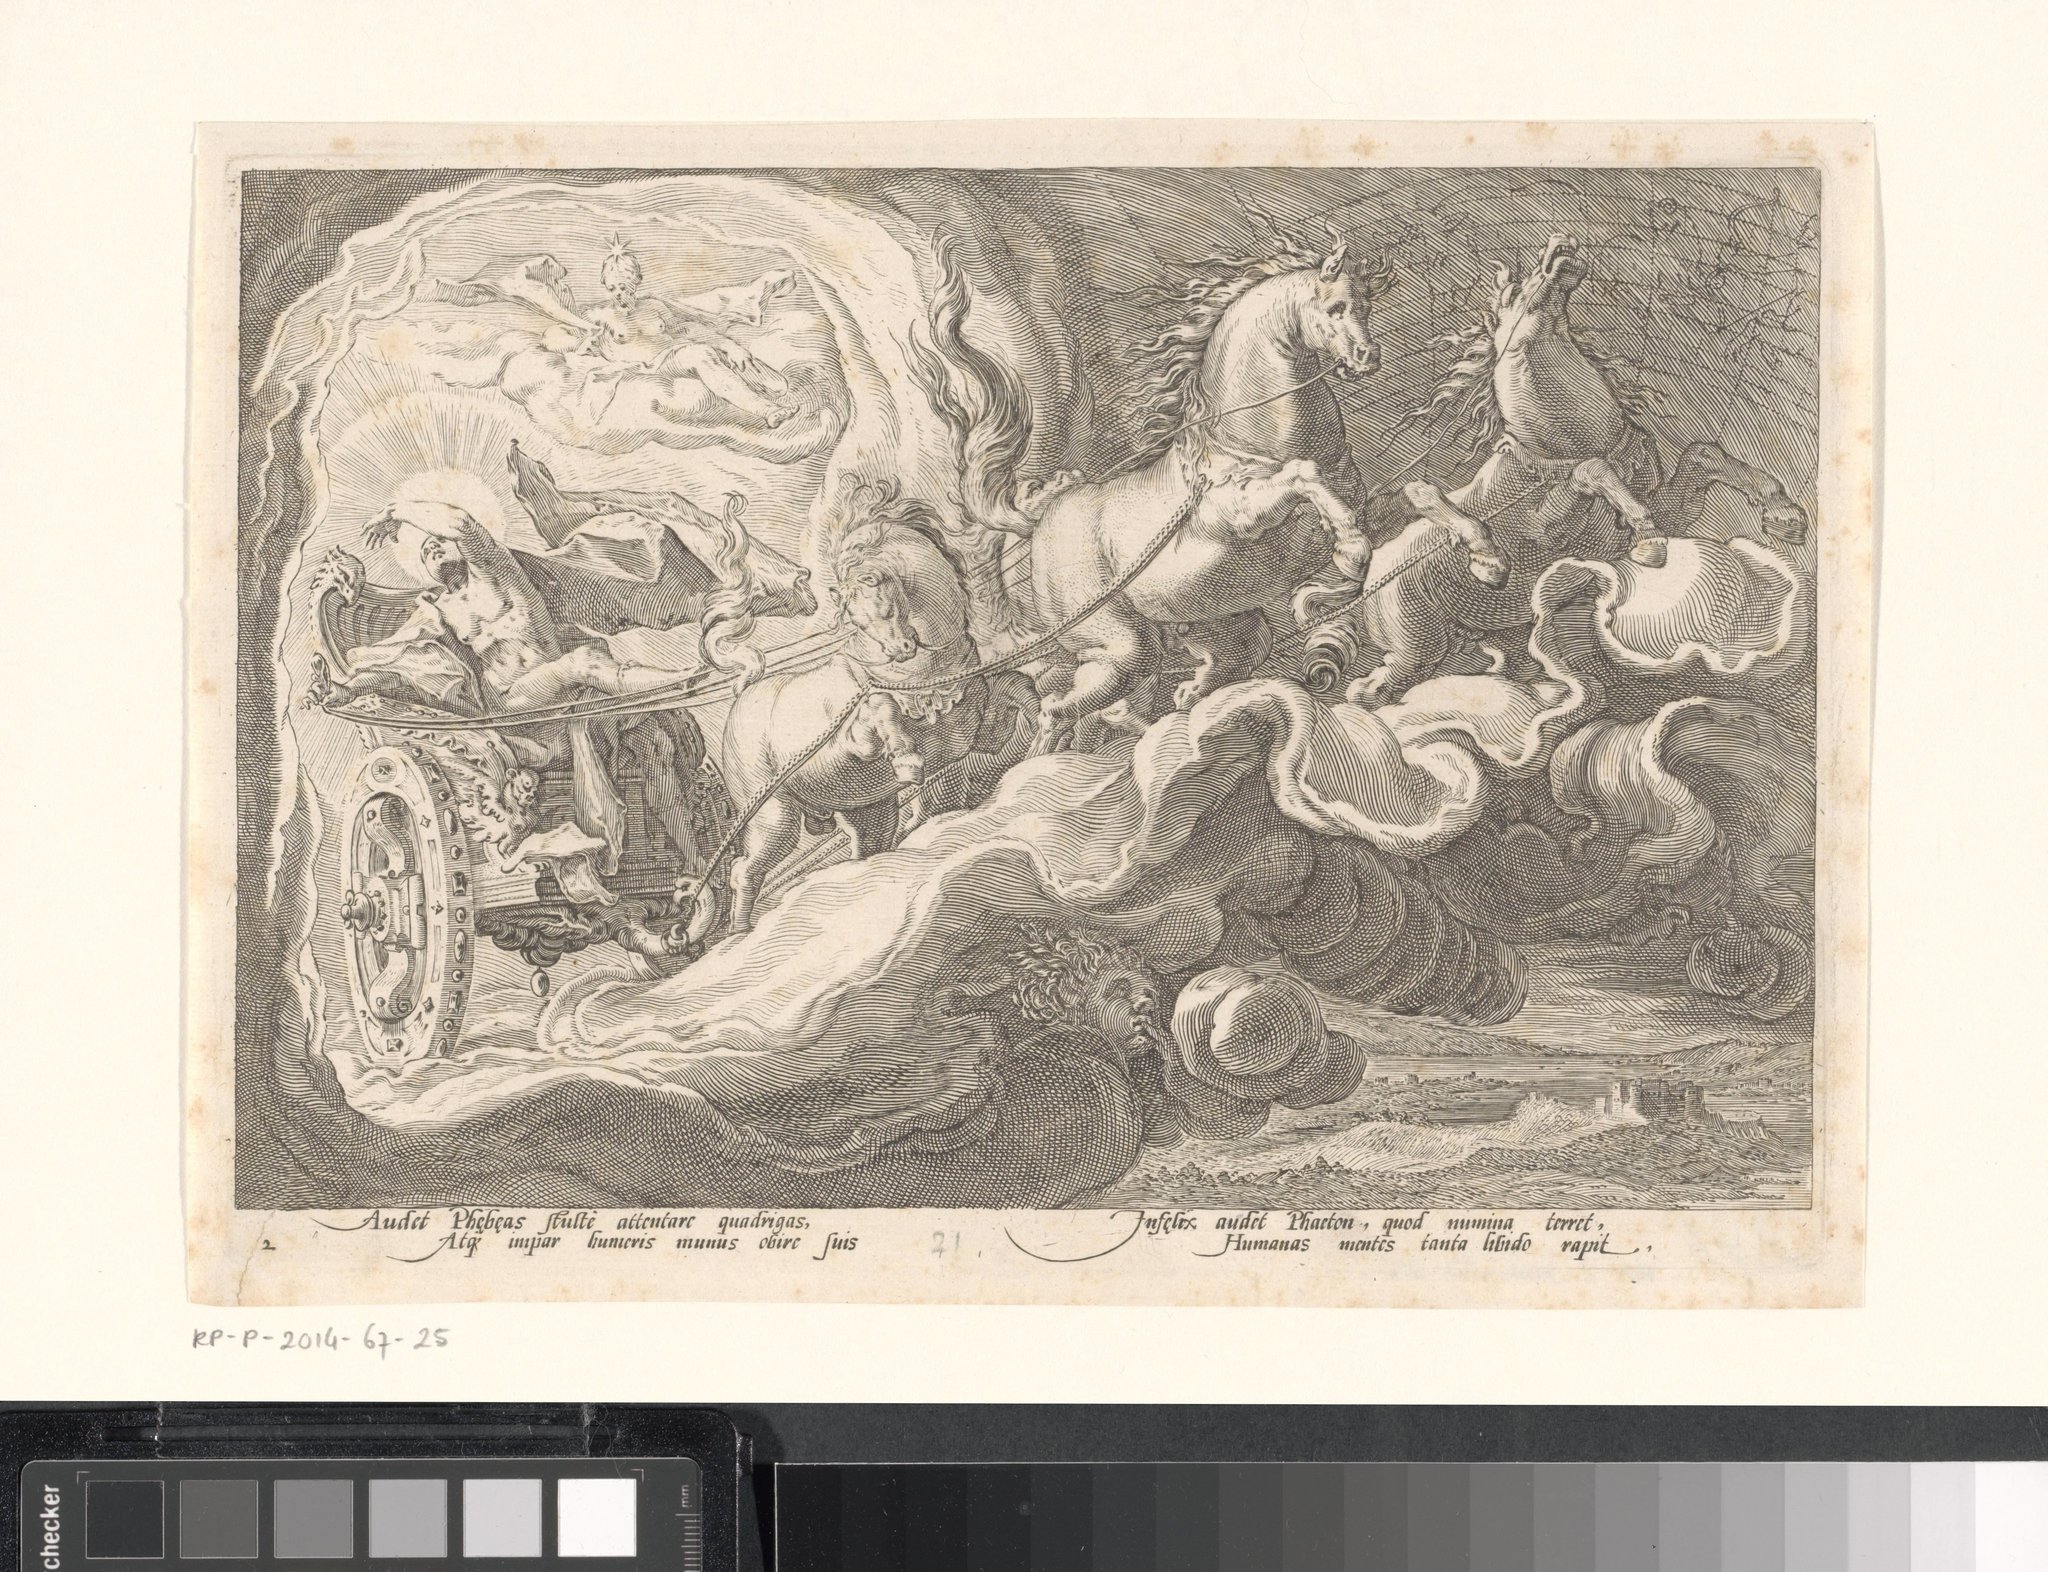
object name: print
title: Metamorfosen van Ovidius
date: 1590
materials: paper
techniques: engraving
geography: haarlem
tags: phaethon drives the chariot of the sun; the earth is threatened with conflagration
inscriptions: collector's mark: ‘Hinloopen’, collector's mark: Lugt 11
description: Phaëthon, de zoon van Apollo, rijdt in zijn vaders zonnewagen en staat op het punt om de macht over de teugels te verliezen. De godin Aurora kijkt vanaf haar wolk toe. Onderaan een vloedgolf. In de ondermarge een vierregelige toelichting, in twee kolommen, in het Latijn.